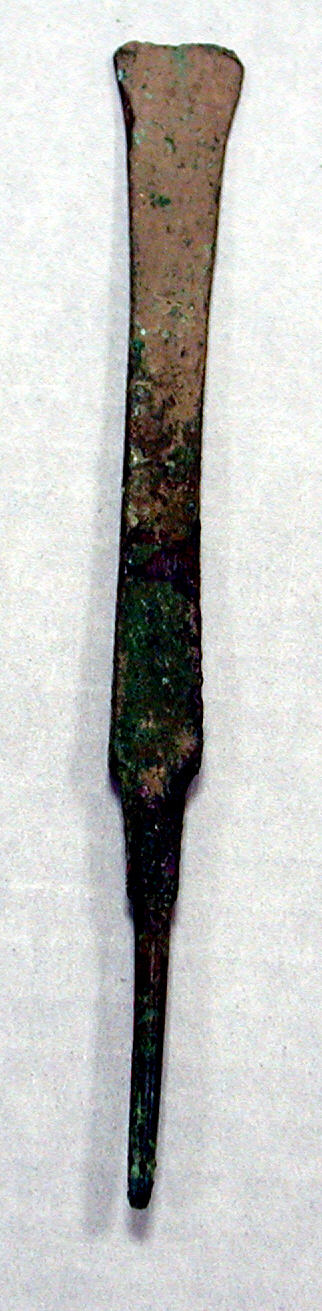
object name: chisel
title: Hammered Copper Chisel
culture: peruvian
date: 1-1566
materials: copper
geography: peru